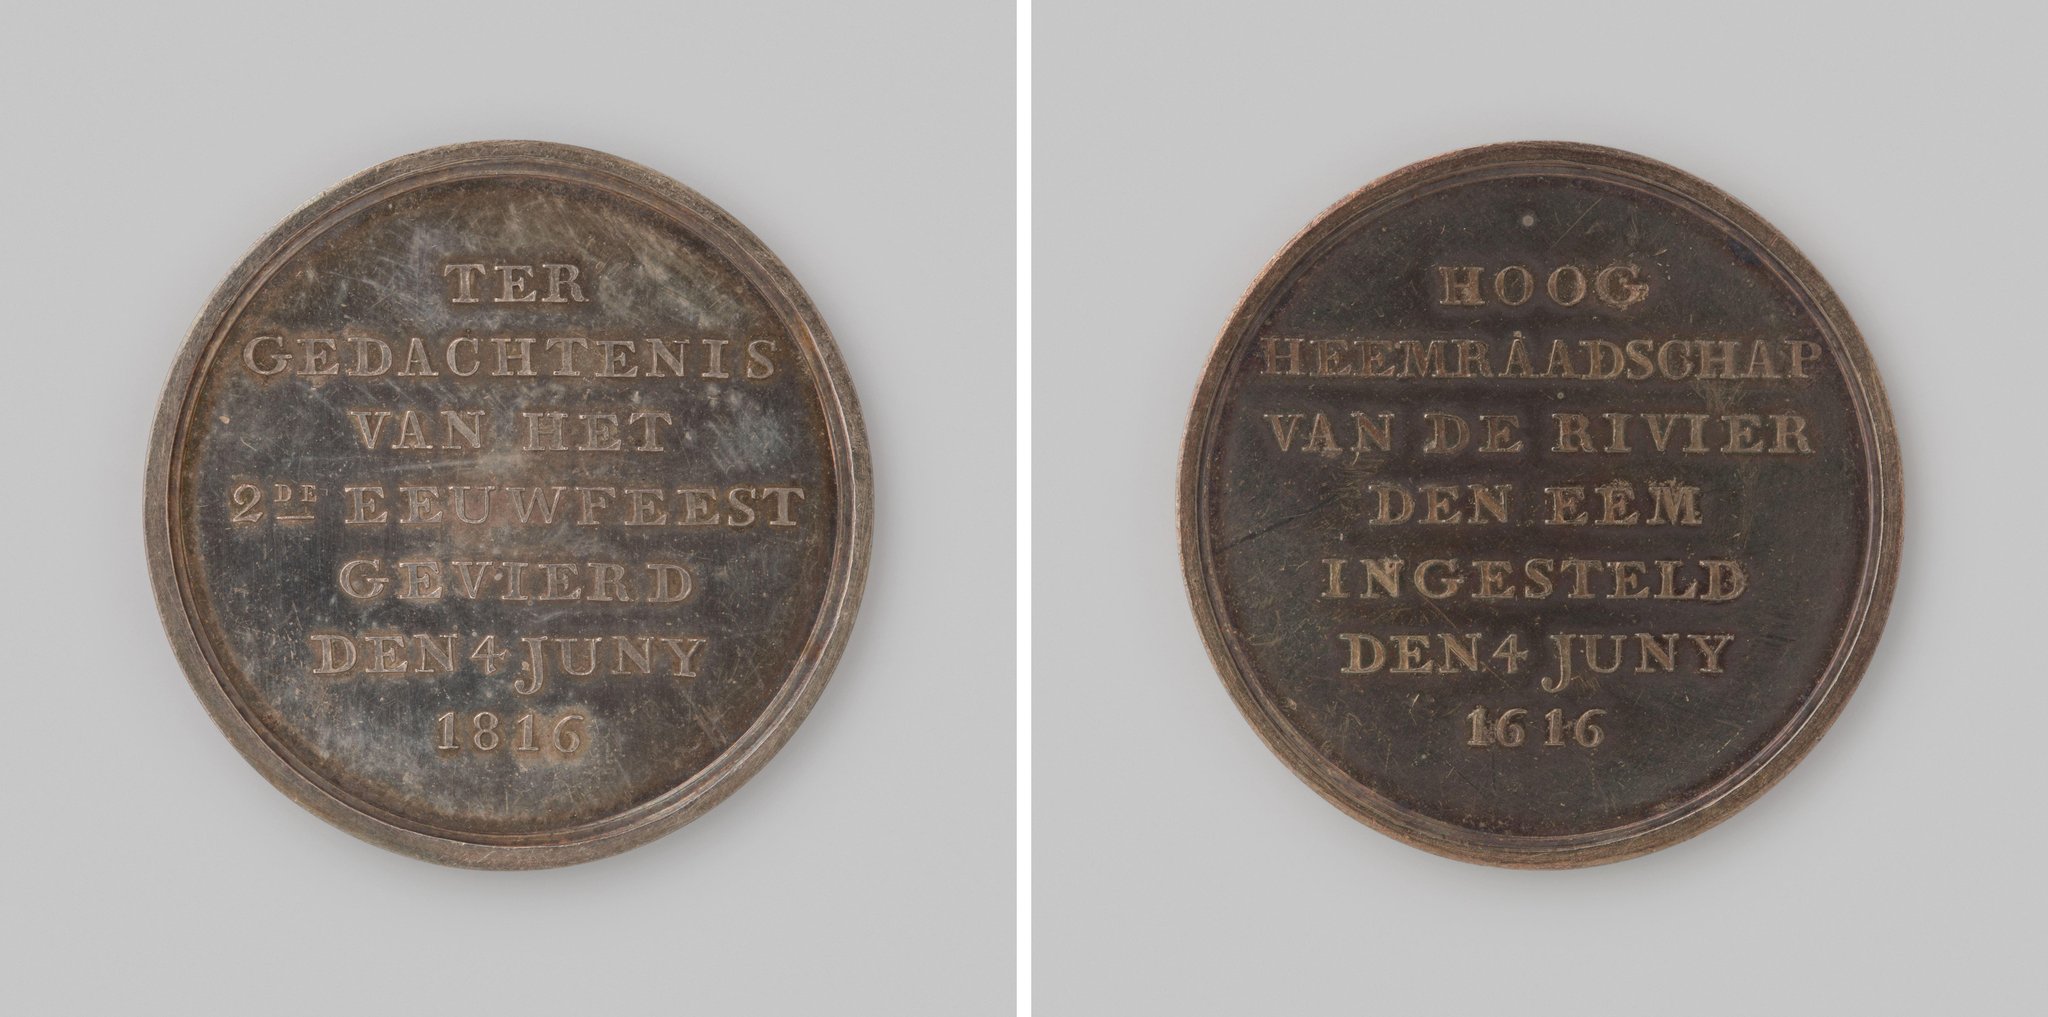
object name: history medal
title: Tweehonderdjarig bestaan van het Hoogheemraadschap van de Eem 1816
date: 1816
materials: silver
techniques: striking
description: Zilveren penning met op voor- en keer zijde zeven regels tekst.